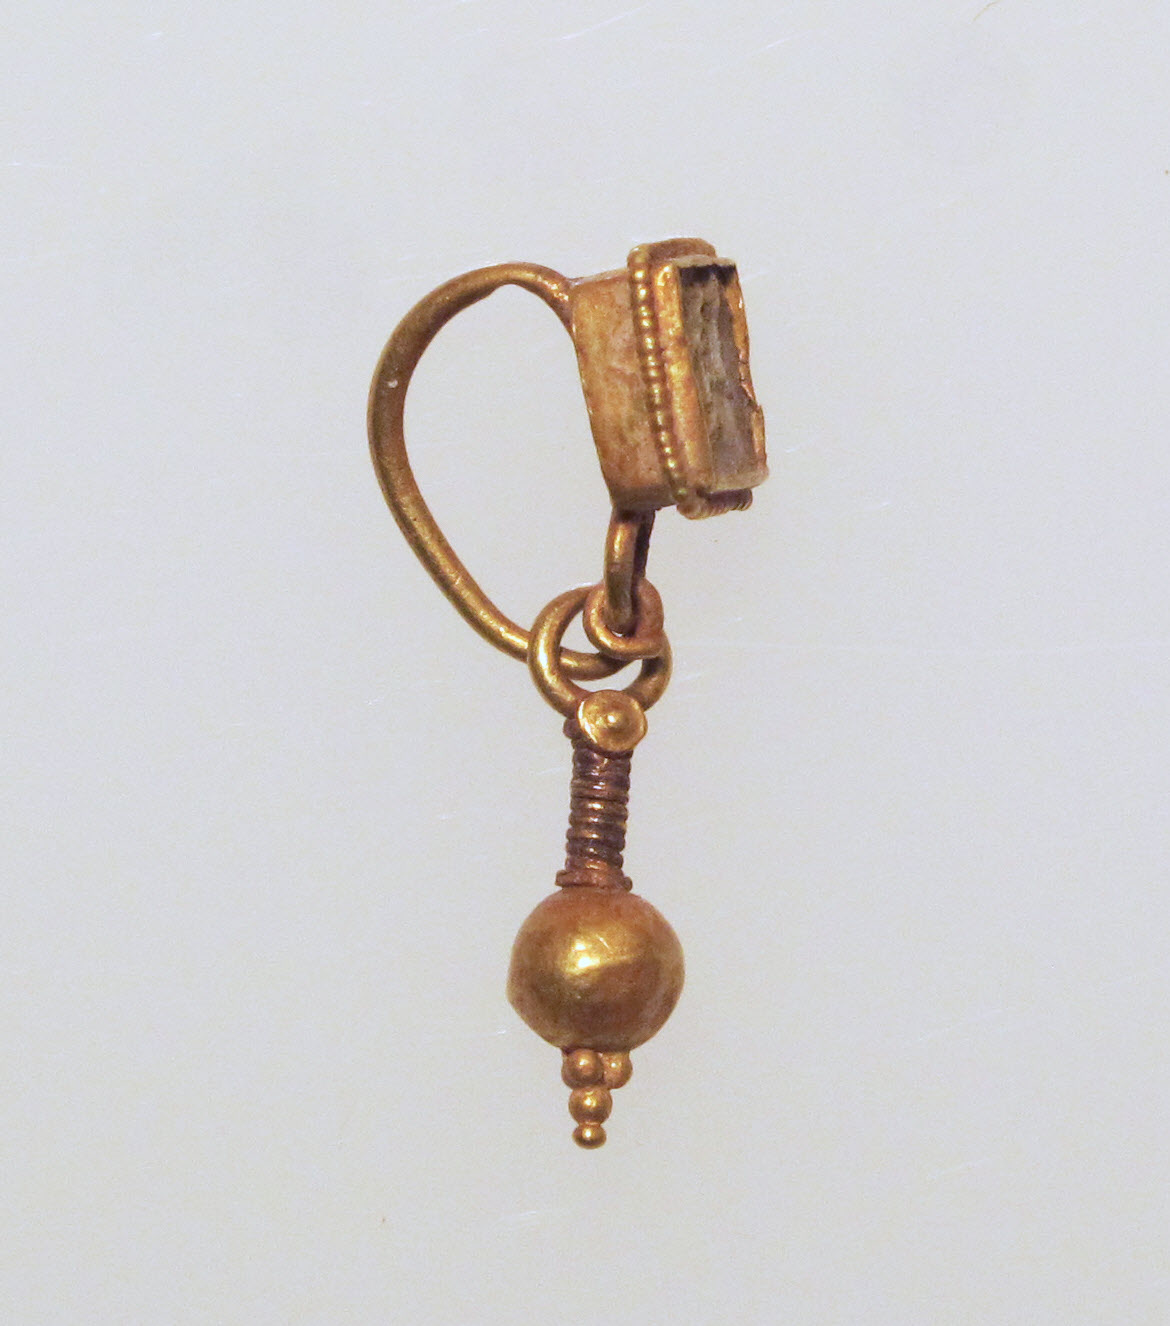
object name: earring with pendant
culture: roman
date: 670 BCE-330 CE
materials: gold